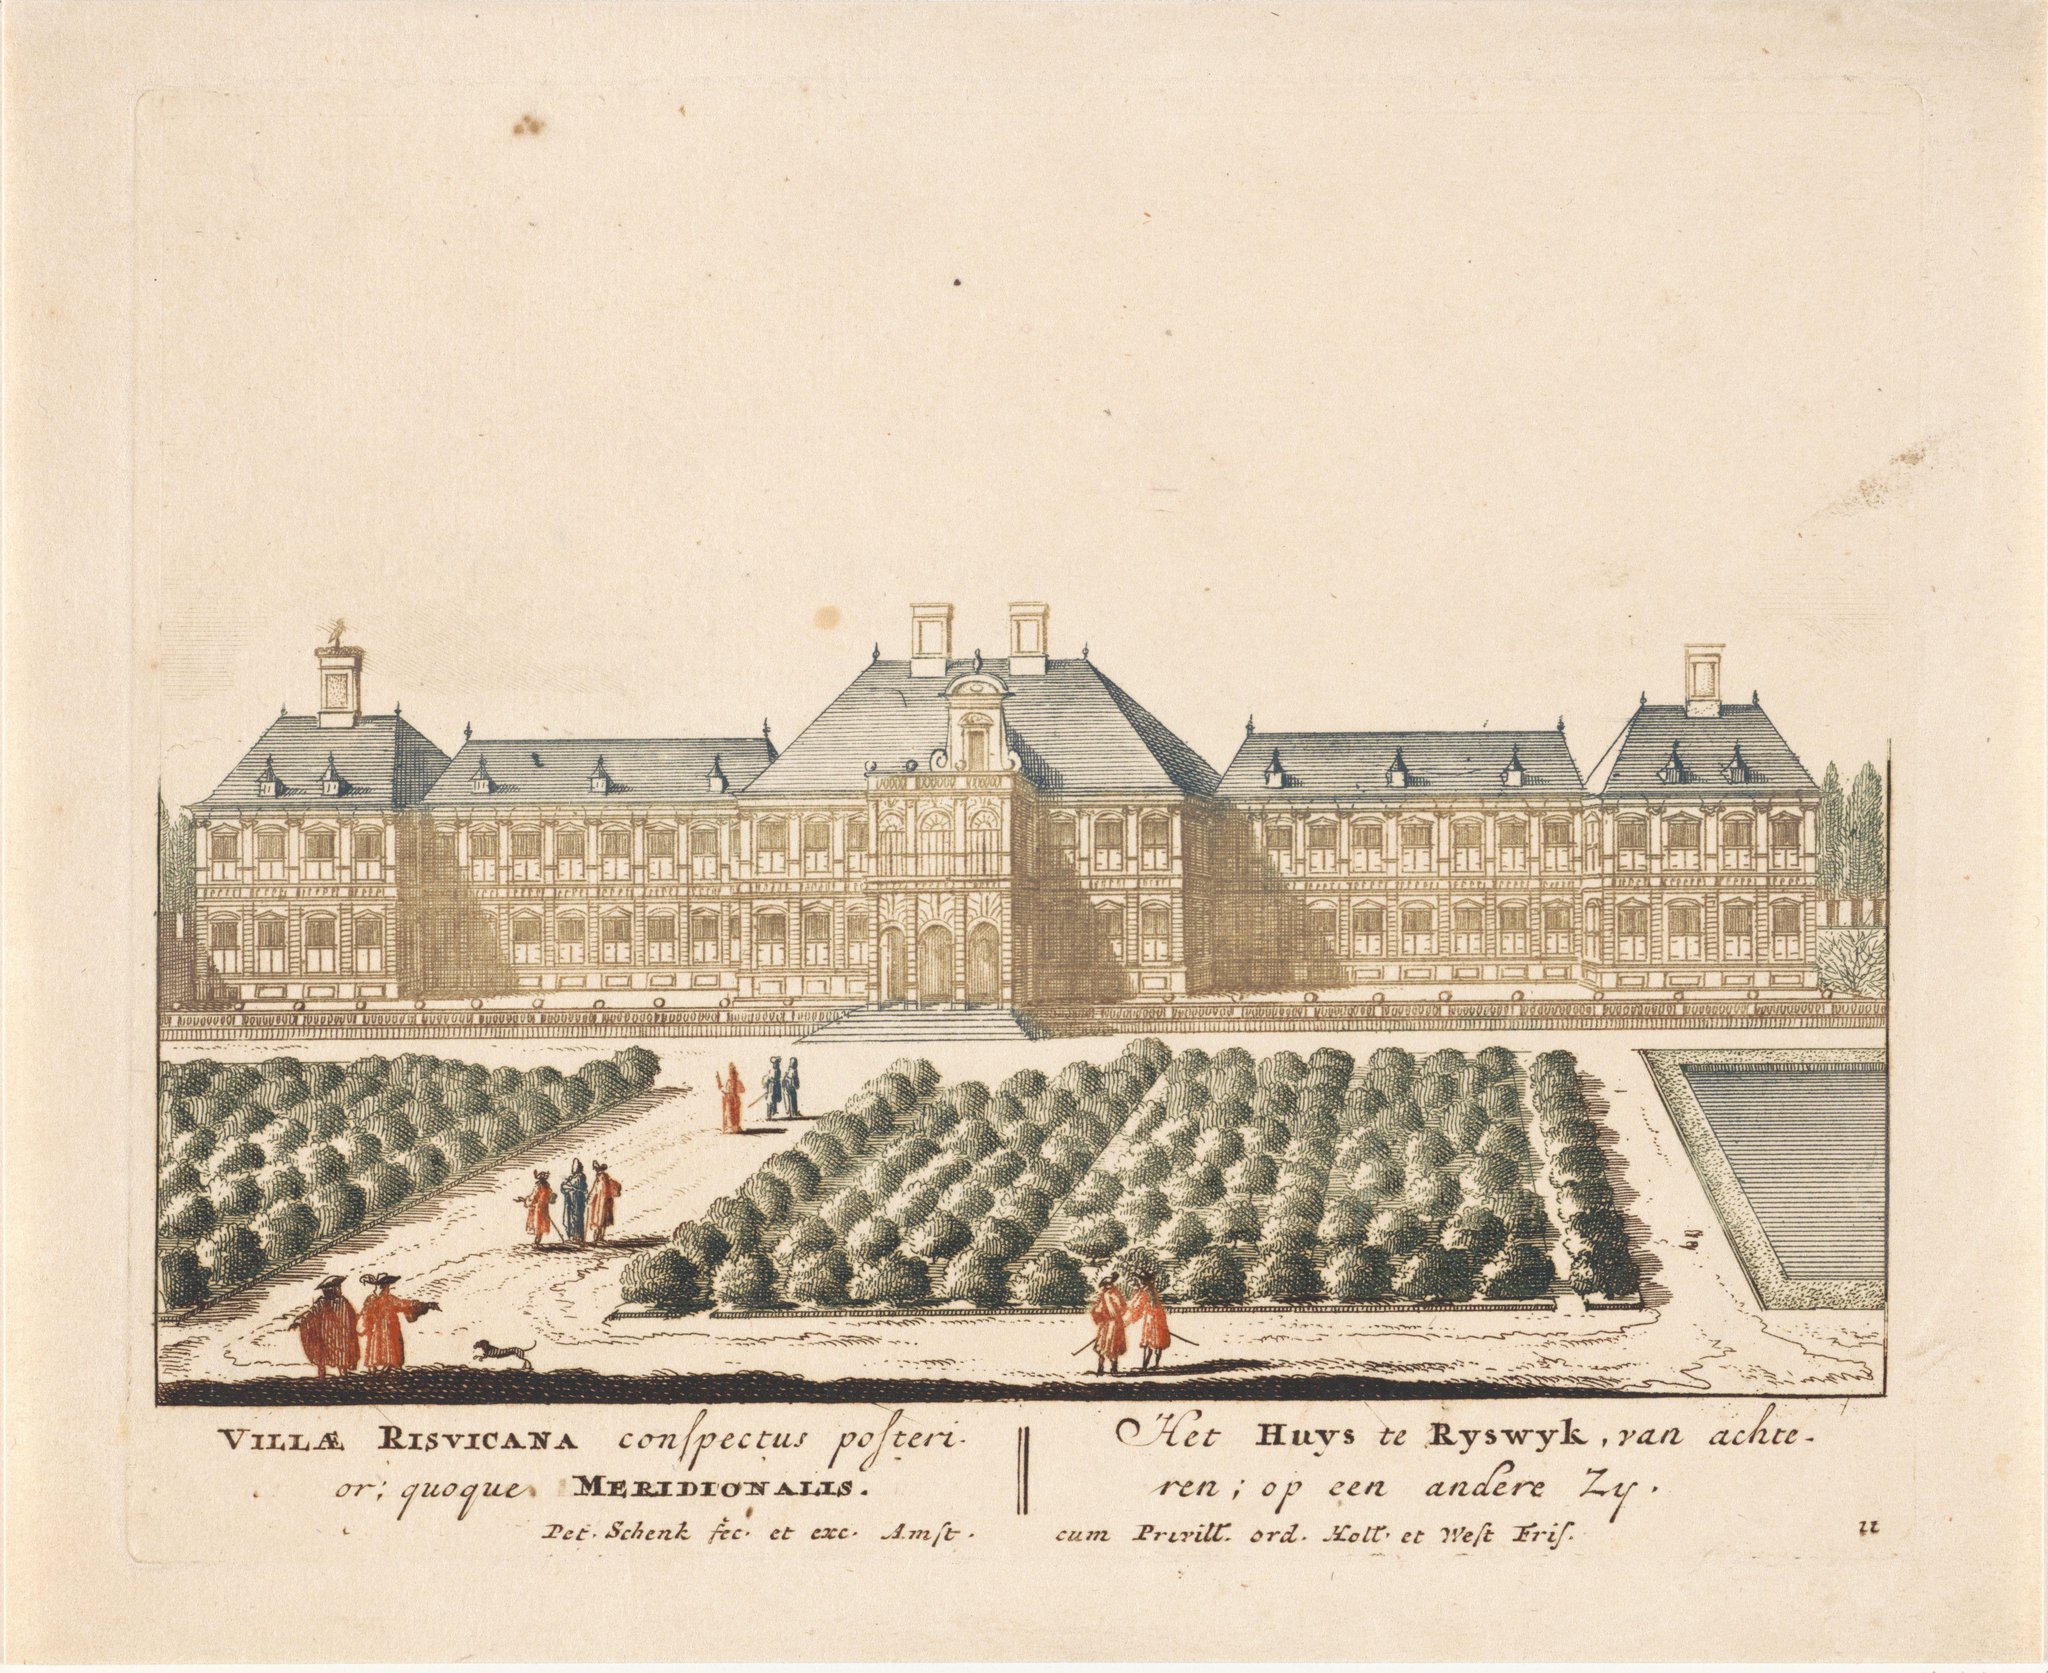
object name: print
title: Het Huys te Ryswyk van achteren; op een andere zy / Villae Risvicana conspectus posterior quoque; meridionalis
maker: pieter schenk (i)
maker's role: print maker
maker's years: 1660-1711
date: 1697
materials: paper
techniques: etching, lithography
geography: amsterdam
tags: palace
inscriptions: collector's mark: Lugt 2228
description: Gezicht op de achterzijde van Huis ter Nieuburch te Rijswijk.